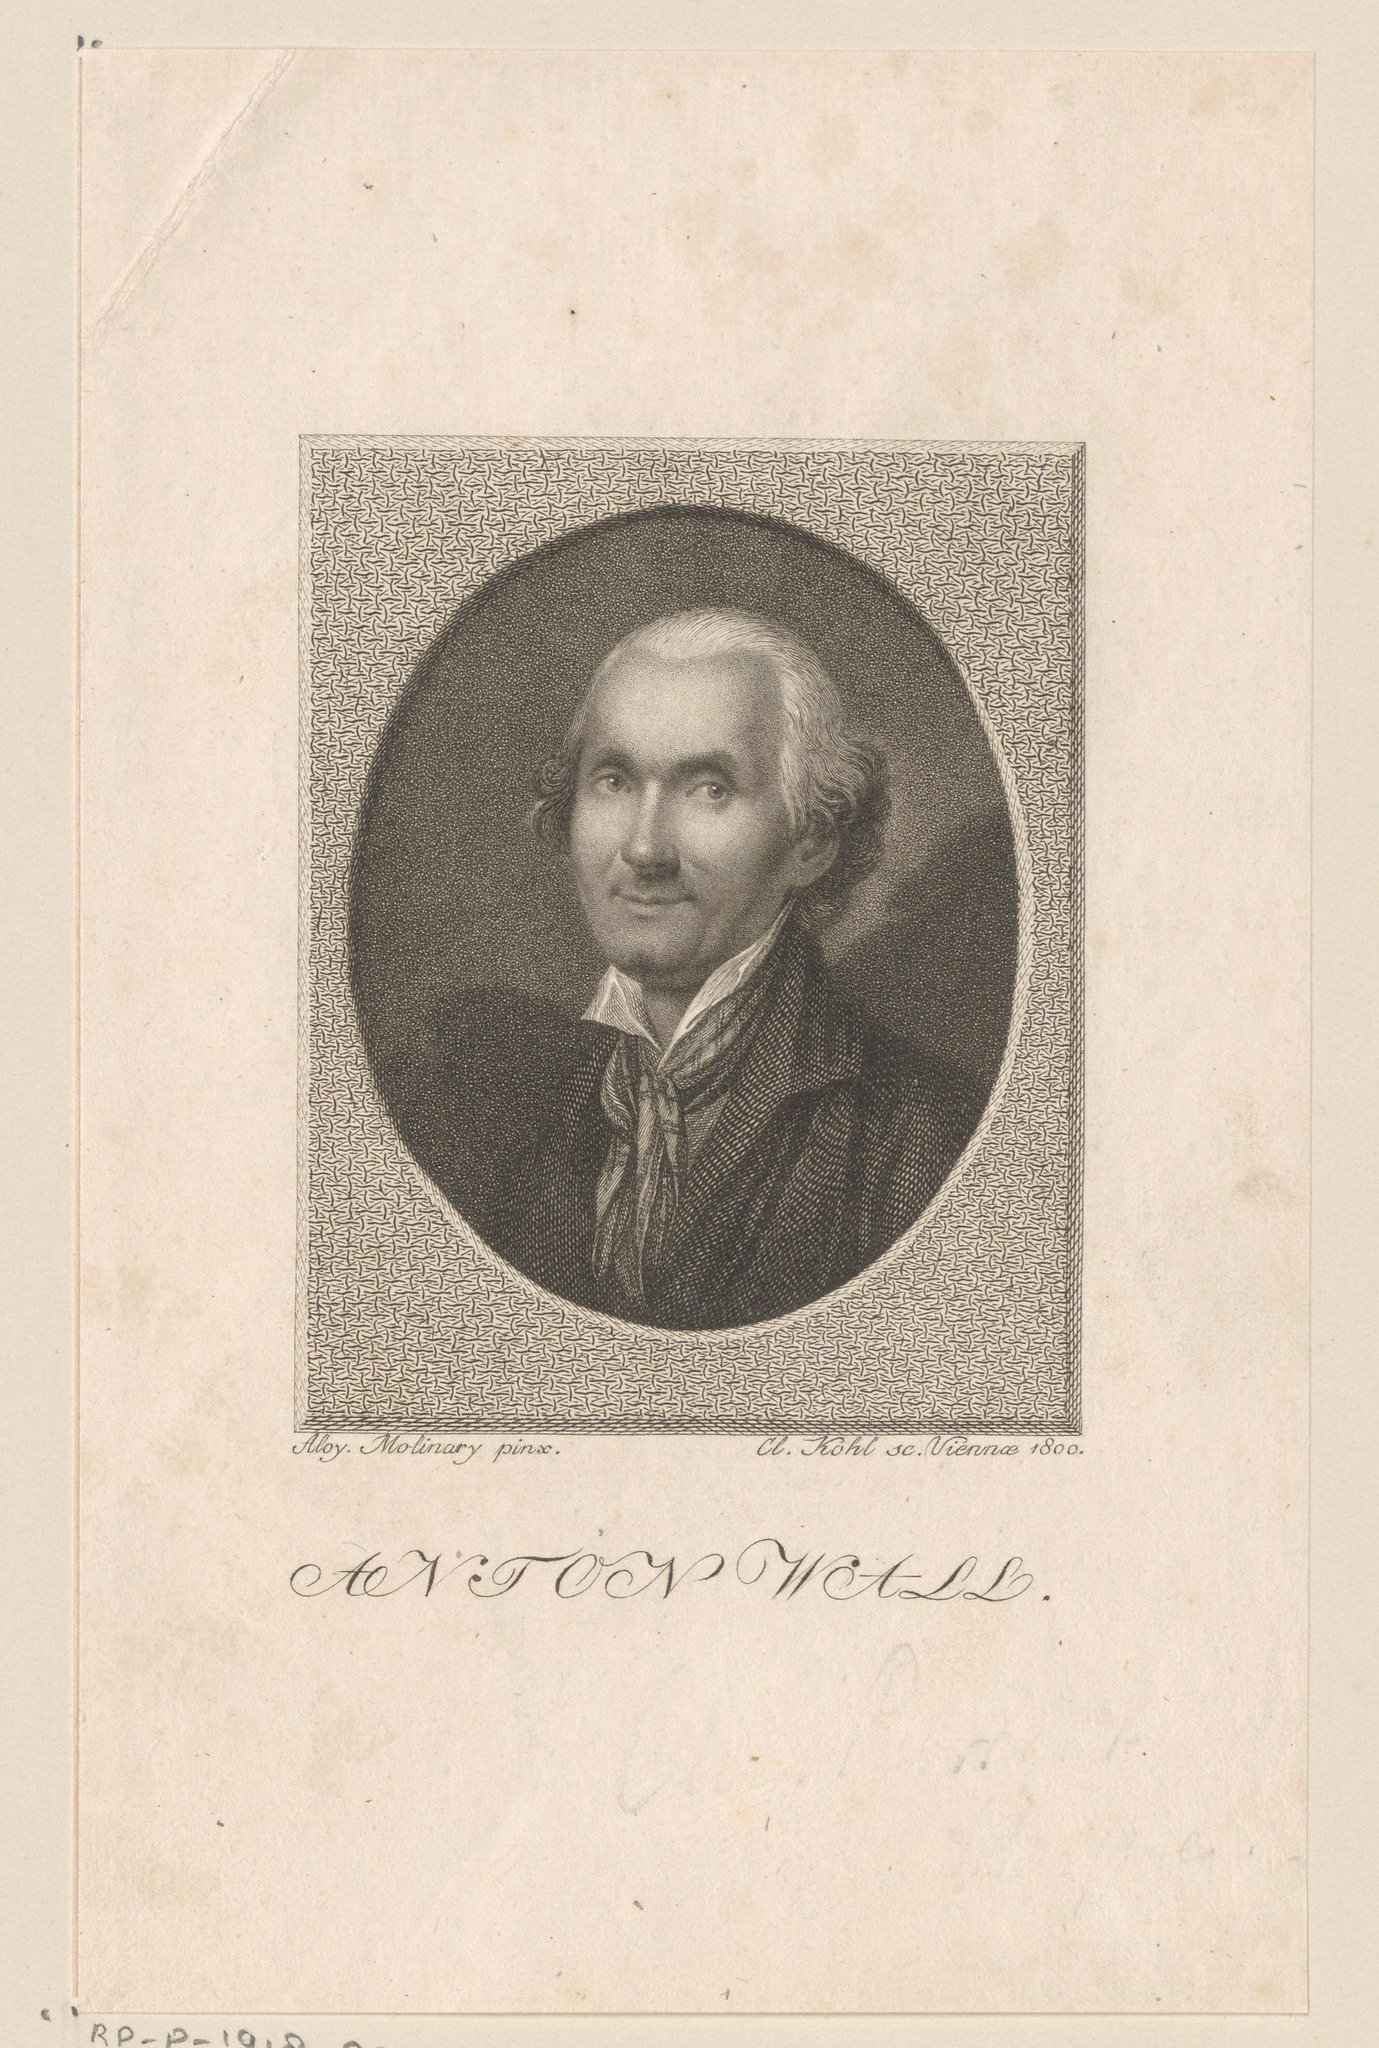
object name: print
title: Portret van Christian Leberecht Heyne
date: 1800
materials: paper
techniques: engraving, etching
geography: vienna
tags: historical persons, portrait of a writer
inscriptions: collector's mark: Lugt 2233